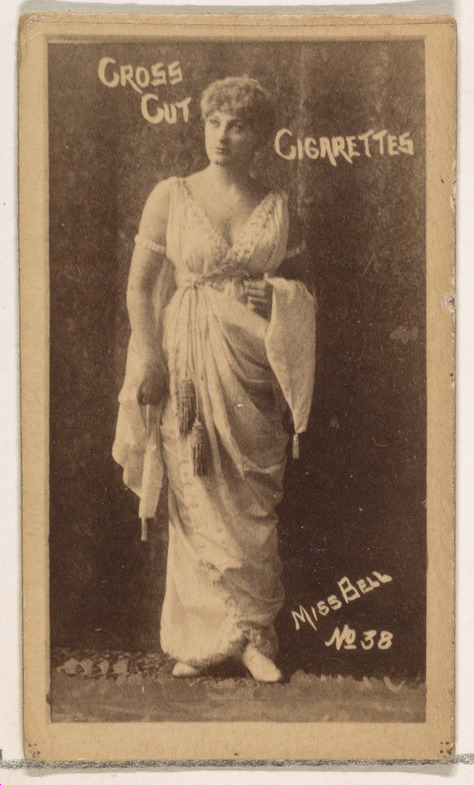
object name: print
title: Card Number 38, Miss Bell, from the Actors and Actresses series (N145-1) issued by Duke Sons & Co. to promote Cross Cut Cigarettes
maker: w. duke, sons & co.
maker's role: publisher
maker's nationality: american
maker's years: 1870-1920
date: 1880-1889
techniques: albumen silver print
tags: portraits,women,actresses